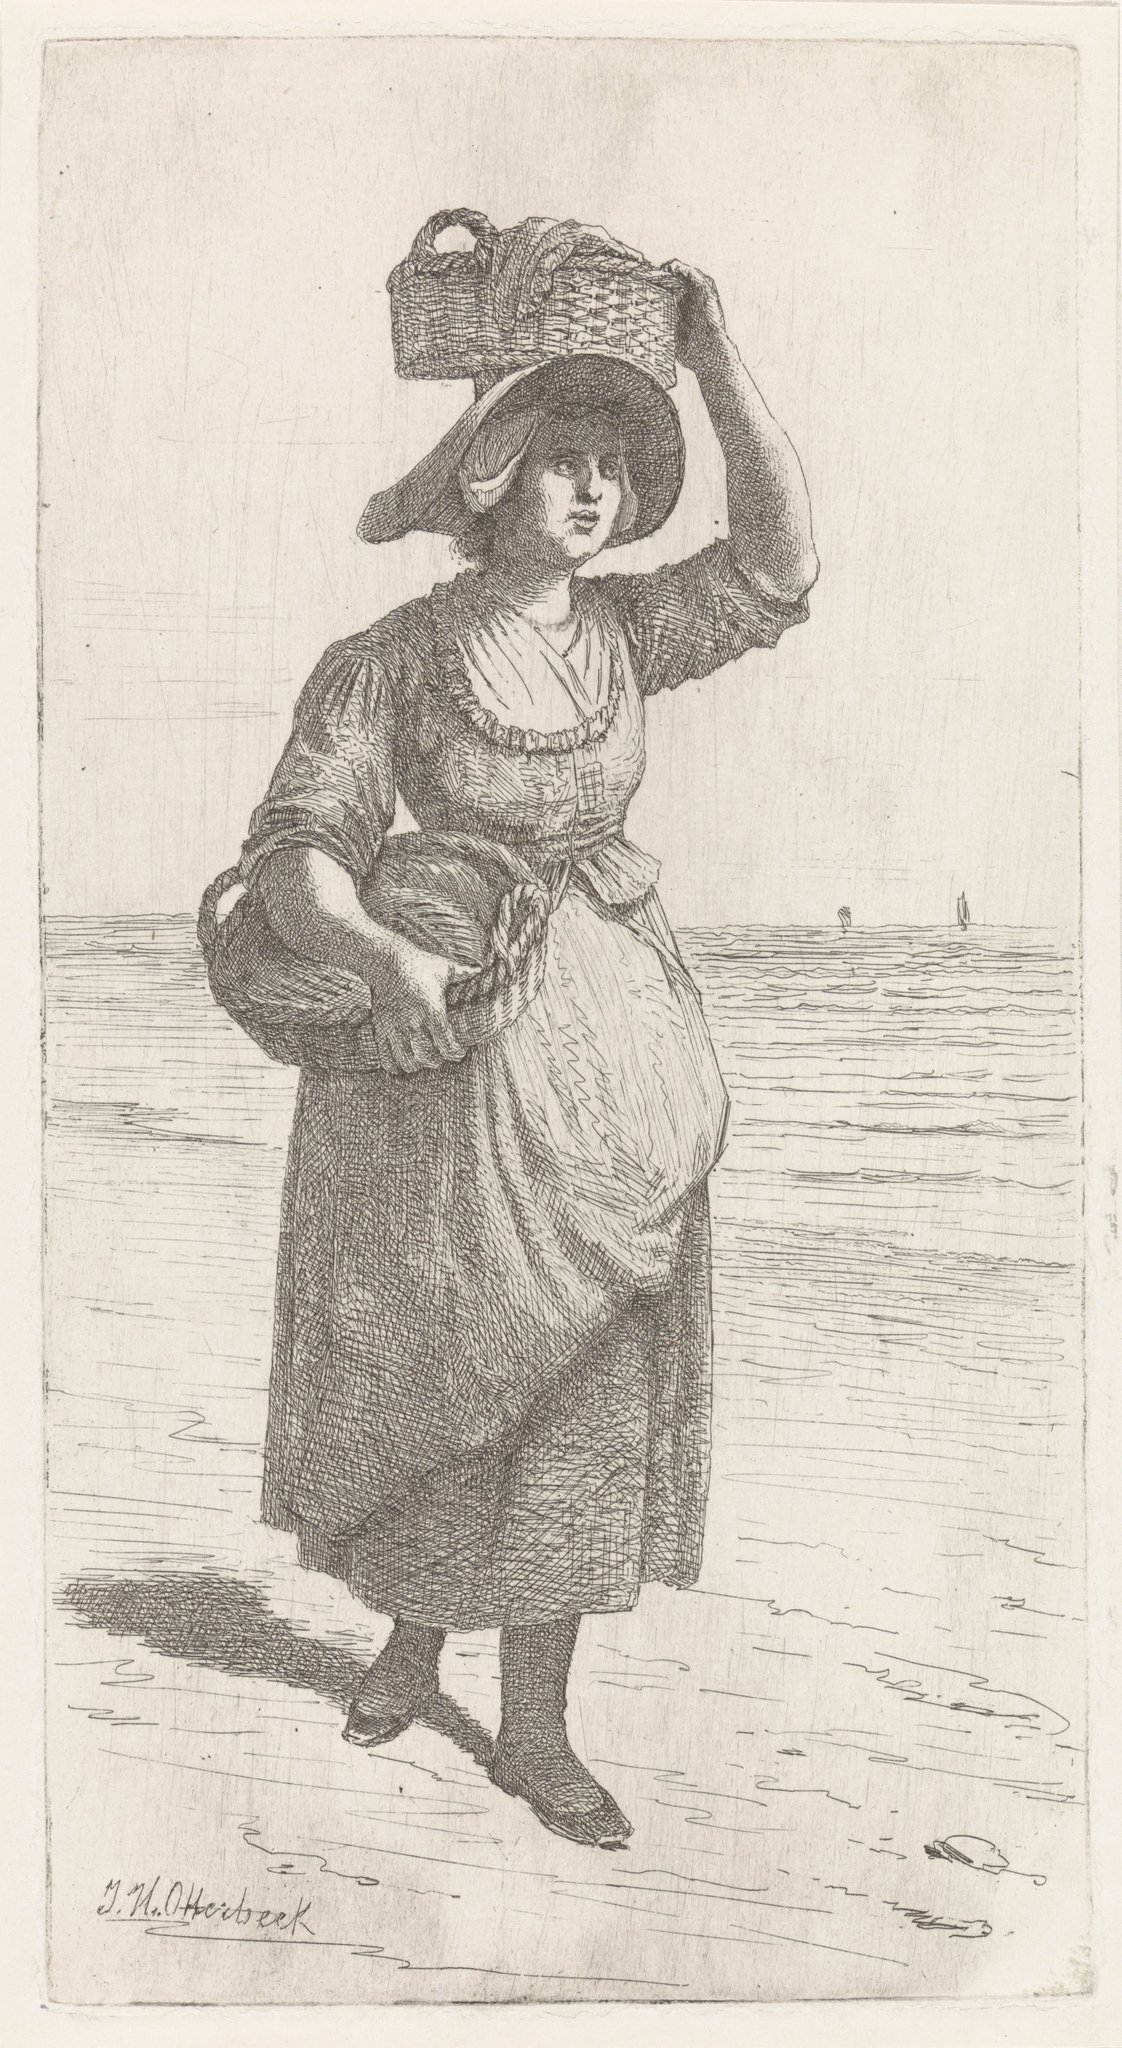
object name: print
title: Vrouw met manden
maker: jacobus hermanus otterbeek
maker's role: painter, print maker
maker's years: 1839-1902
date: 1854-1902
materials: paper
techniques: etching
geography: the hague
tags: carrying something in basket, bag, rucksack, etc.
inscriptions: collector's mark: Lugt 2228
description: Een vrouw loopt op het strand. Ze draagt een mand onder haar arm en eentje op haar hoofd.